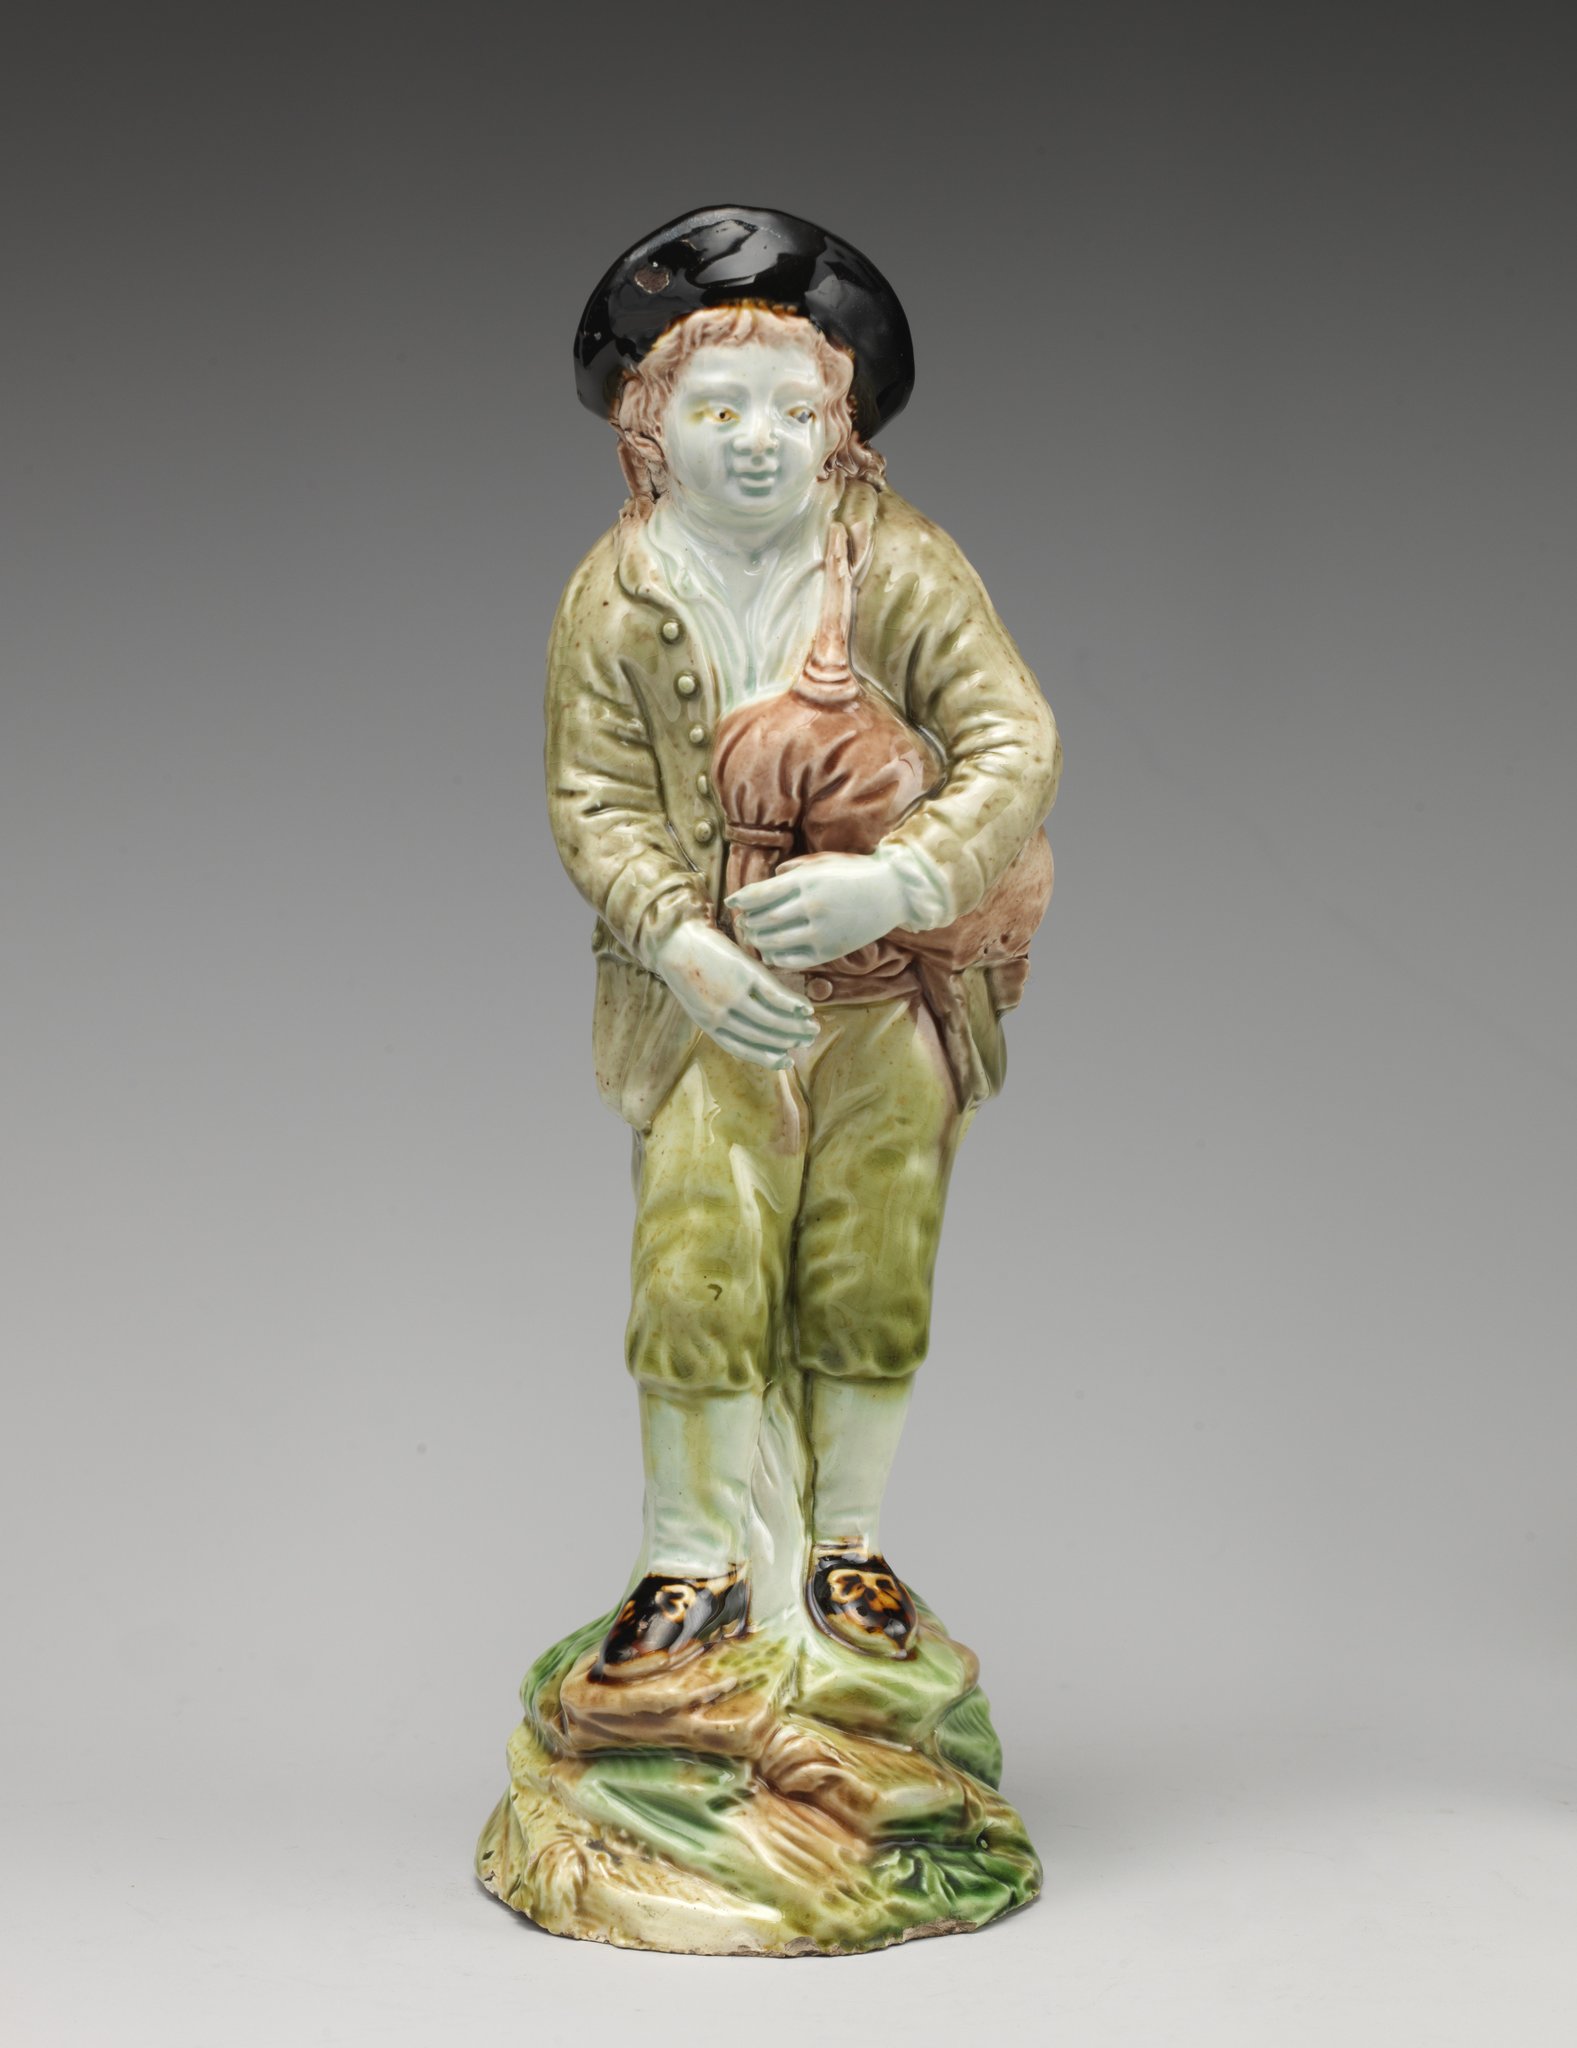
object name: figure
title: Boy with bagpipes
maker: ralph wood the younger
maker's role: maker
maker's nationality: british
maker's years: 1748-1795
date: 1770-1780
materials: earthenware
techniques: glazing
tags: boys,bagpipes